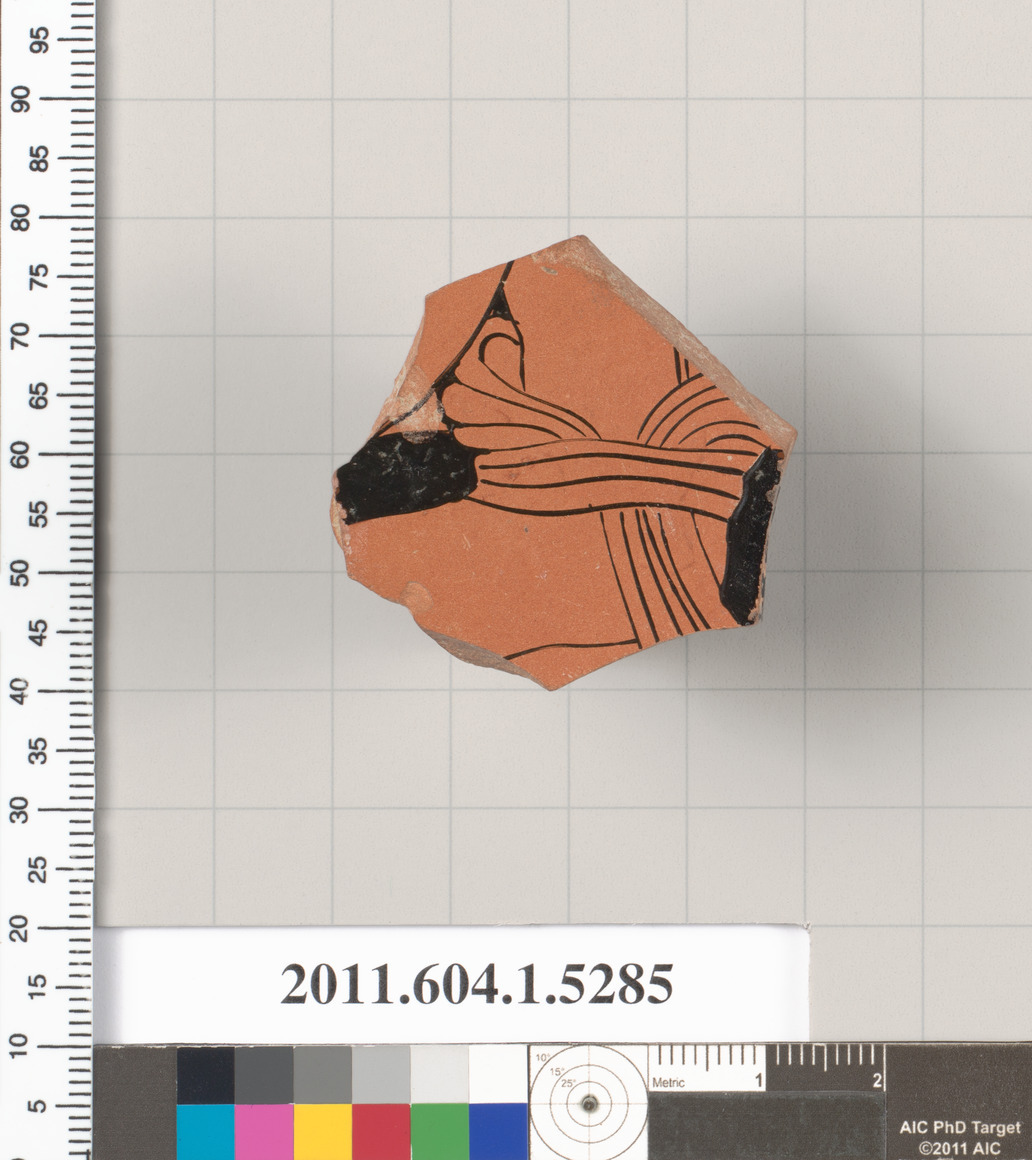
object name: kylix fragment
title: Terracotta fragment of a kylix (drinking cup)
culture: greek, attic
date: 500-480 BCE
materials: terracotta